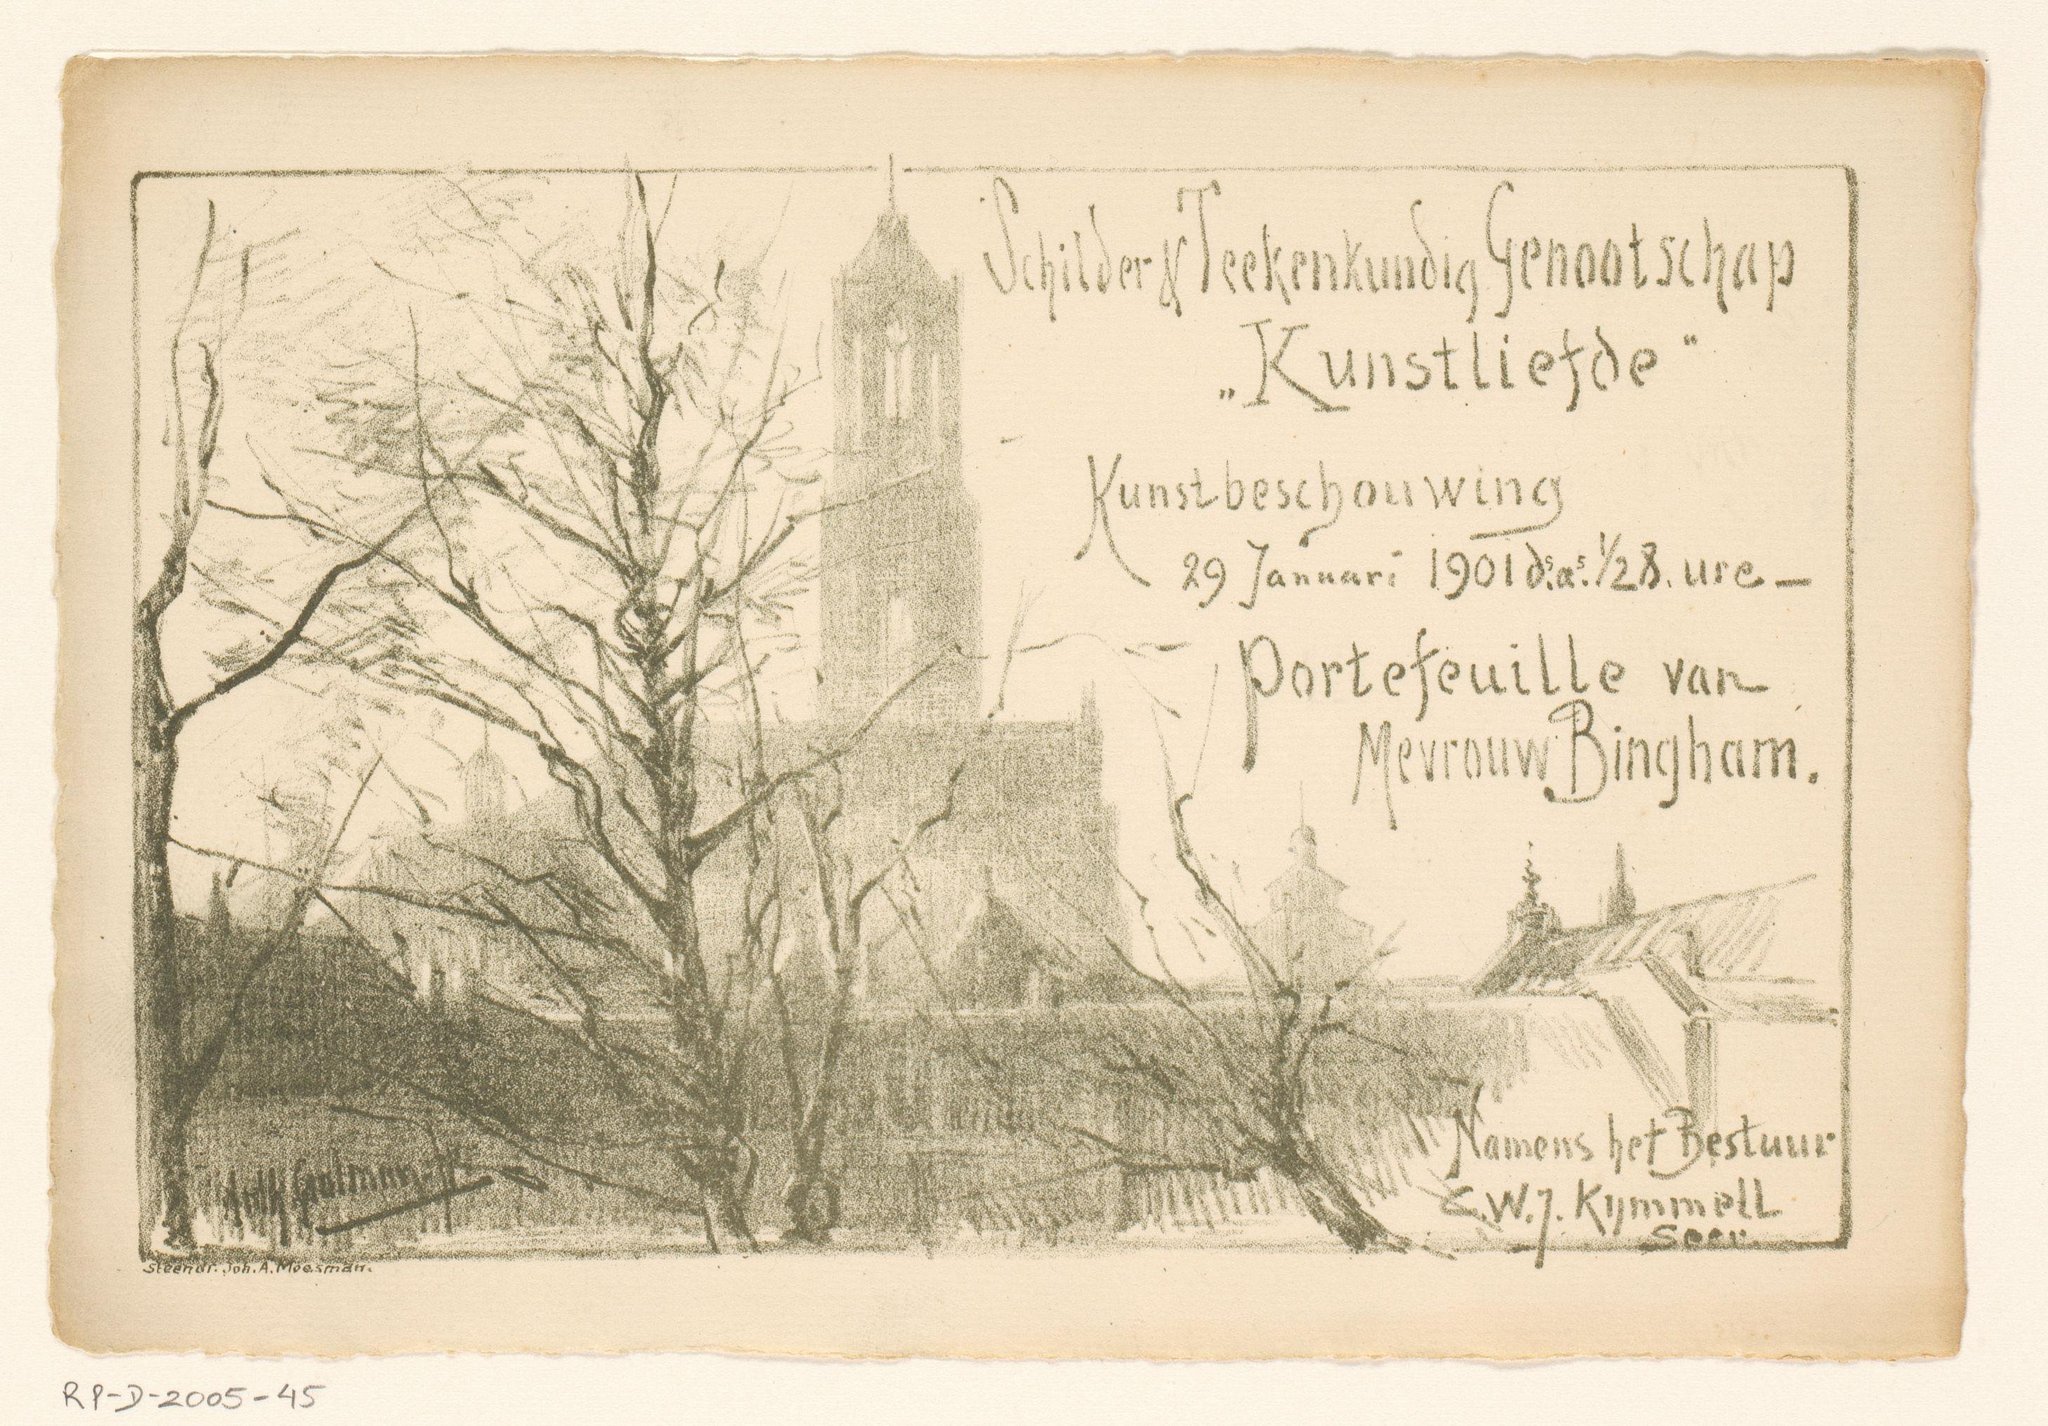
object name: print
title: Uitnodiging van Schilder- en Teekenkundig Genootschap "Kunstliefde" voor een kunstbeschouwing, 29 januari 1901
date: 1901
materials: paper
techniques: lithograph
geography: utrecht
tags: criticizing and discussing art, art criticism, circle, club of artists, collecting and exhibiting products of the fine arts, church (exterior)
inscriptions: collector's mark: Lugt 2228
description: Gezicht op de Domtoren te Utrecht. Uitnodiging van Schilder- en Teekenkundig Genootschap "Kunstliefde" voor een kunstbeschouwing op 29 januari 1901 van de portefeuille van mevrouw Bingham.